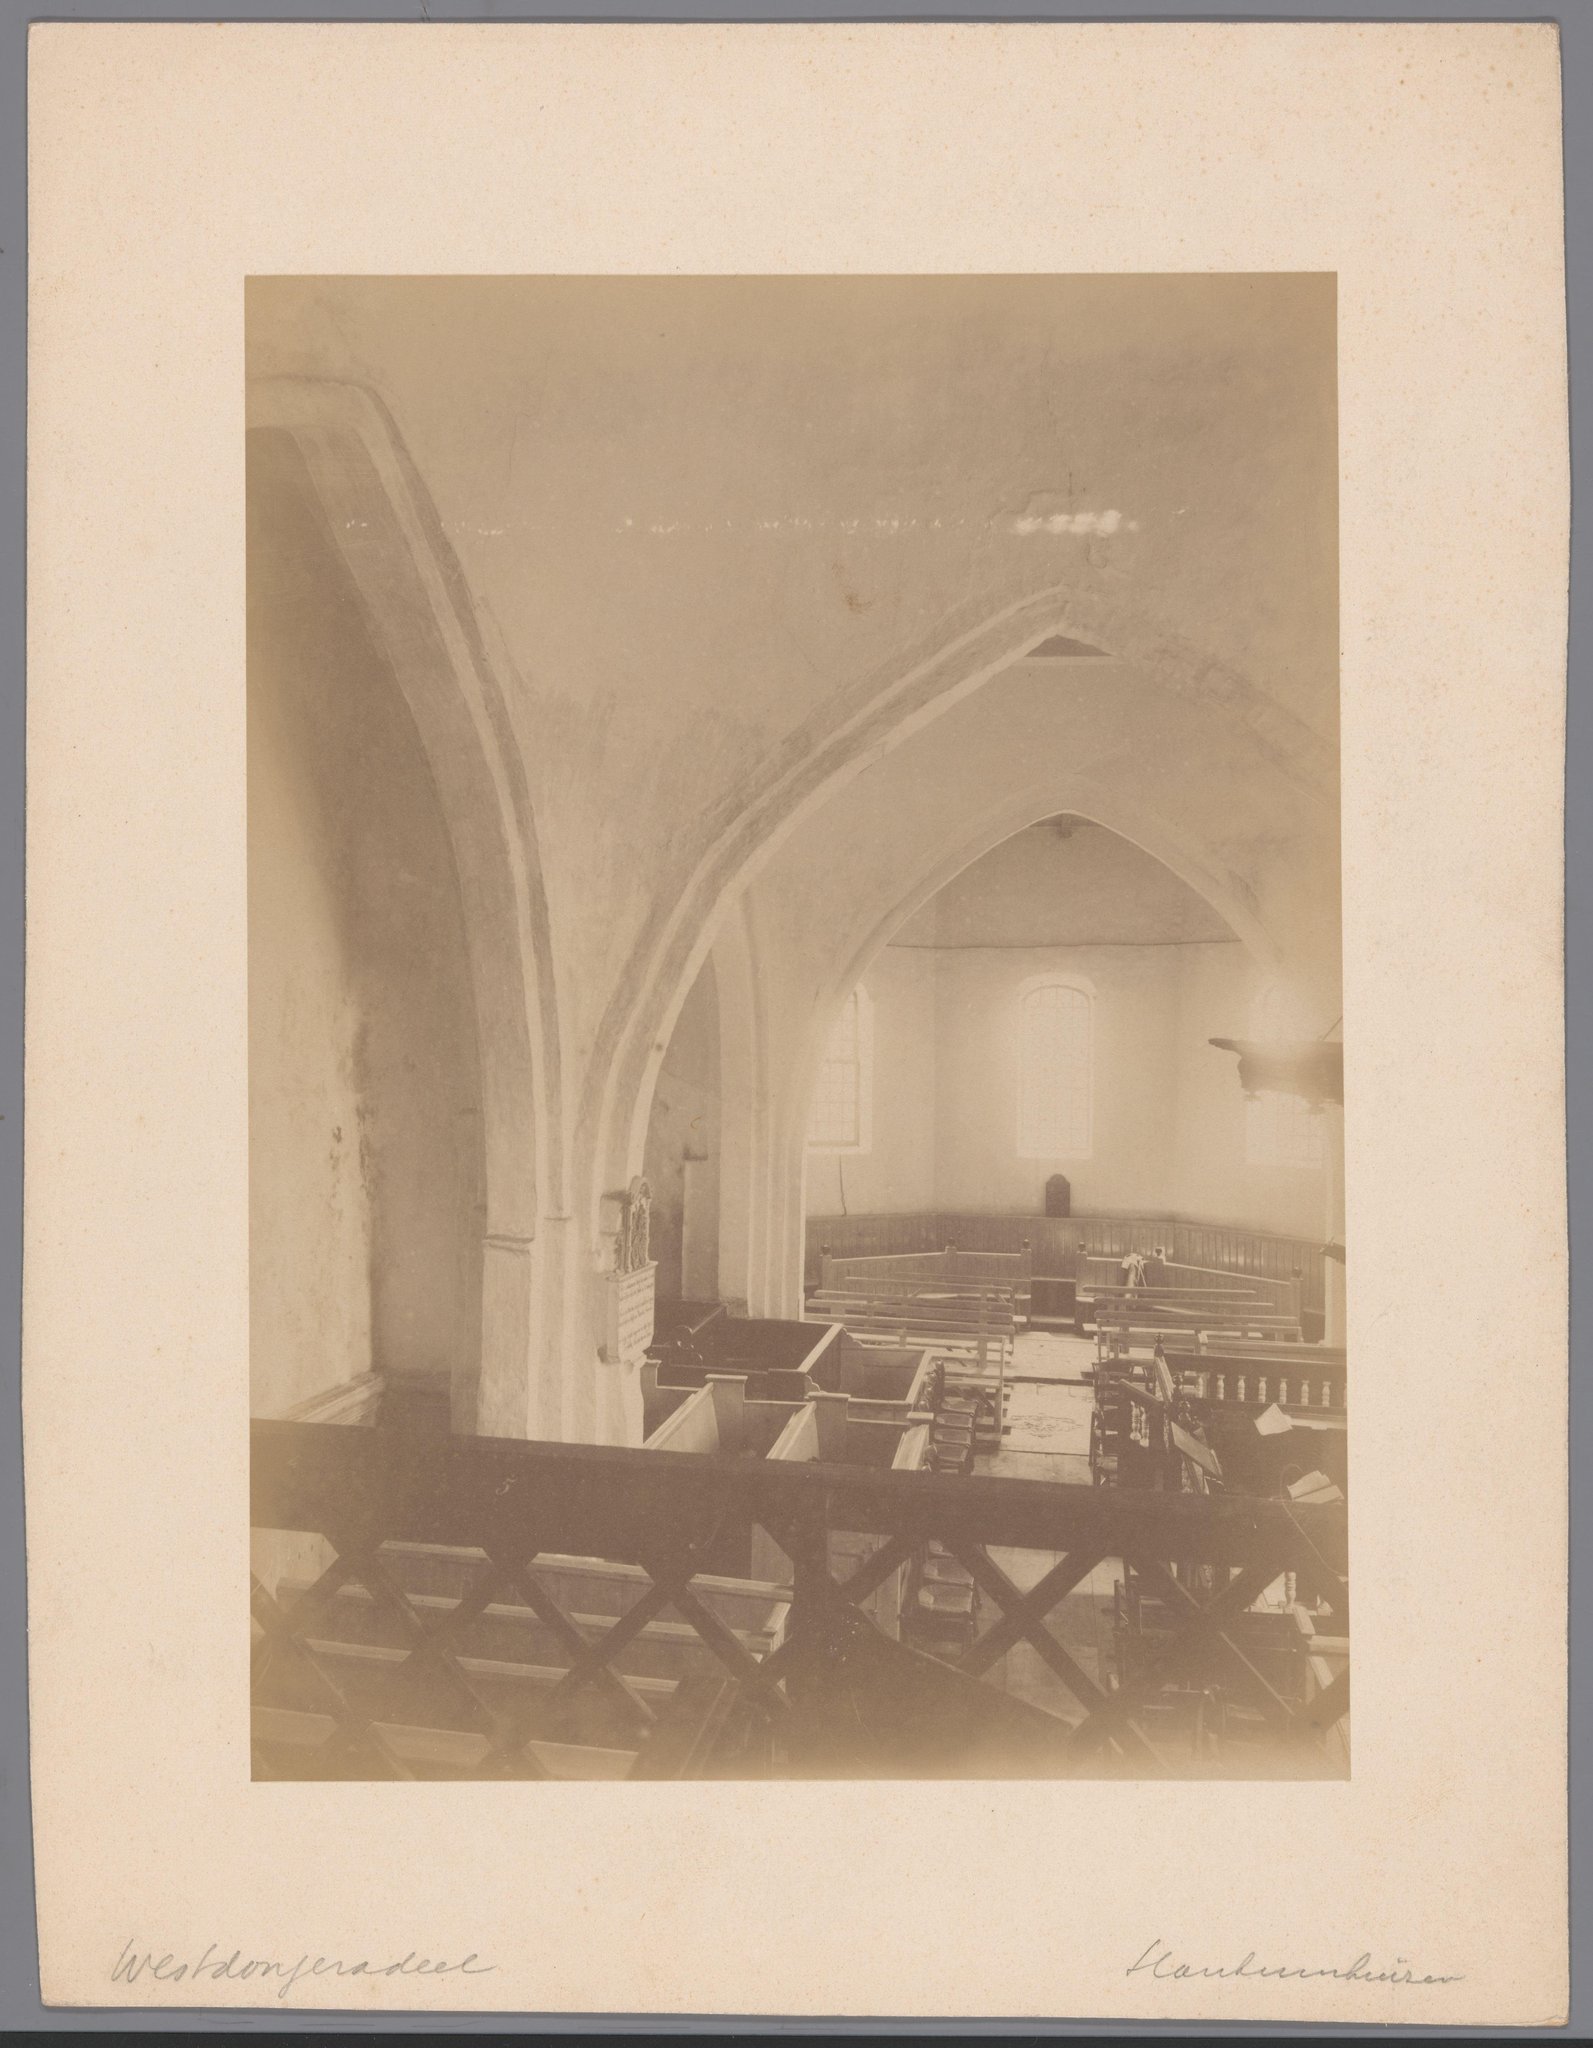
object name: photograph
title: Interieur van de Sint-Annakerk te Hantumhuizen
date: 1900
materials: cardboard, photographic support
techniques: albumen print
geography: hantumhuizen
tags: interior of church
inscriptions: annotation: ‘Westdongeradeel/ Hantumhuizen’, annotation: ‘Hantumhuizen (Hantumhuizen, Fr.) / binnenaanzicht N.H. Kerk / Augustus 1900’